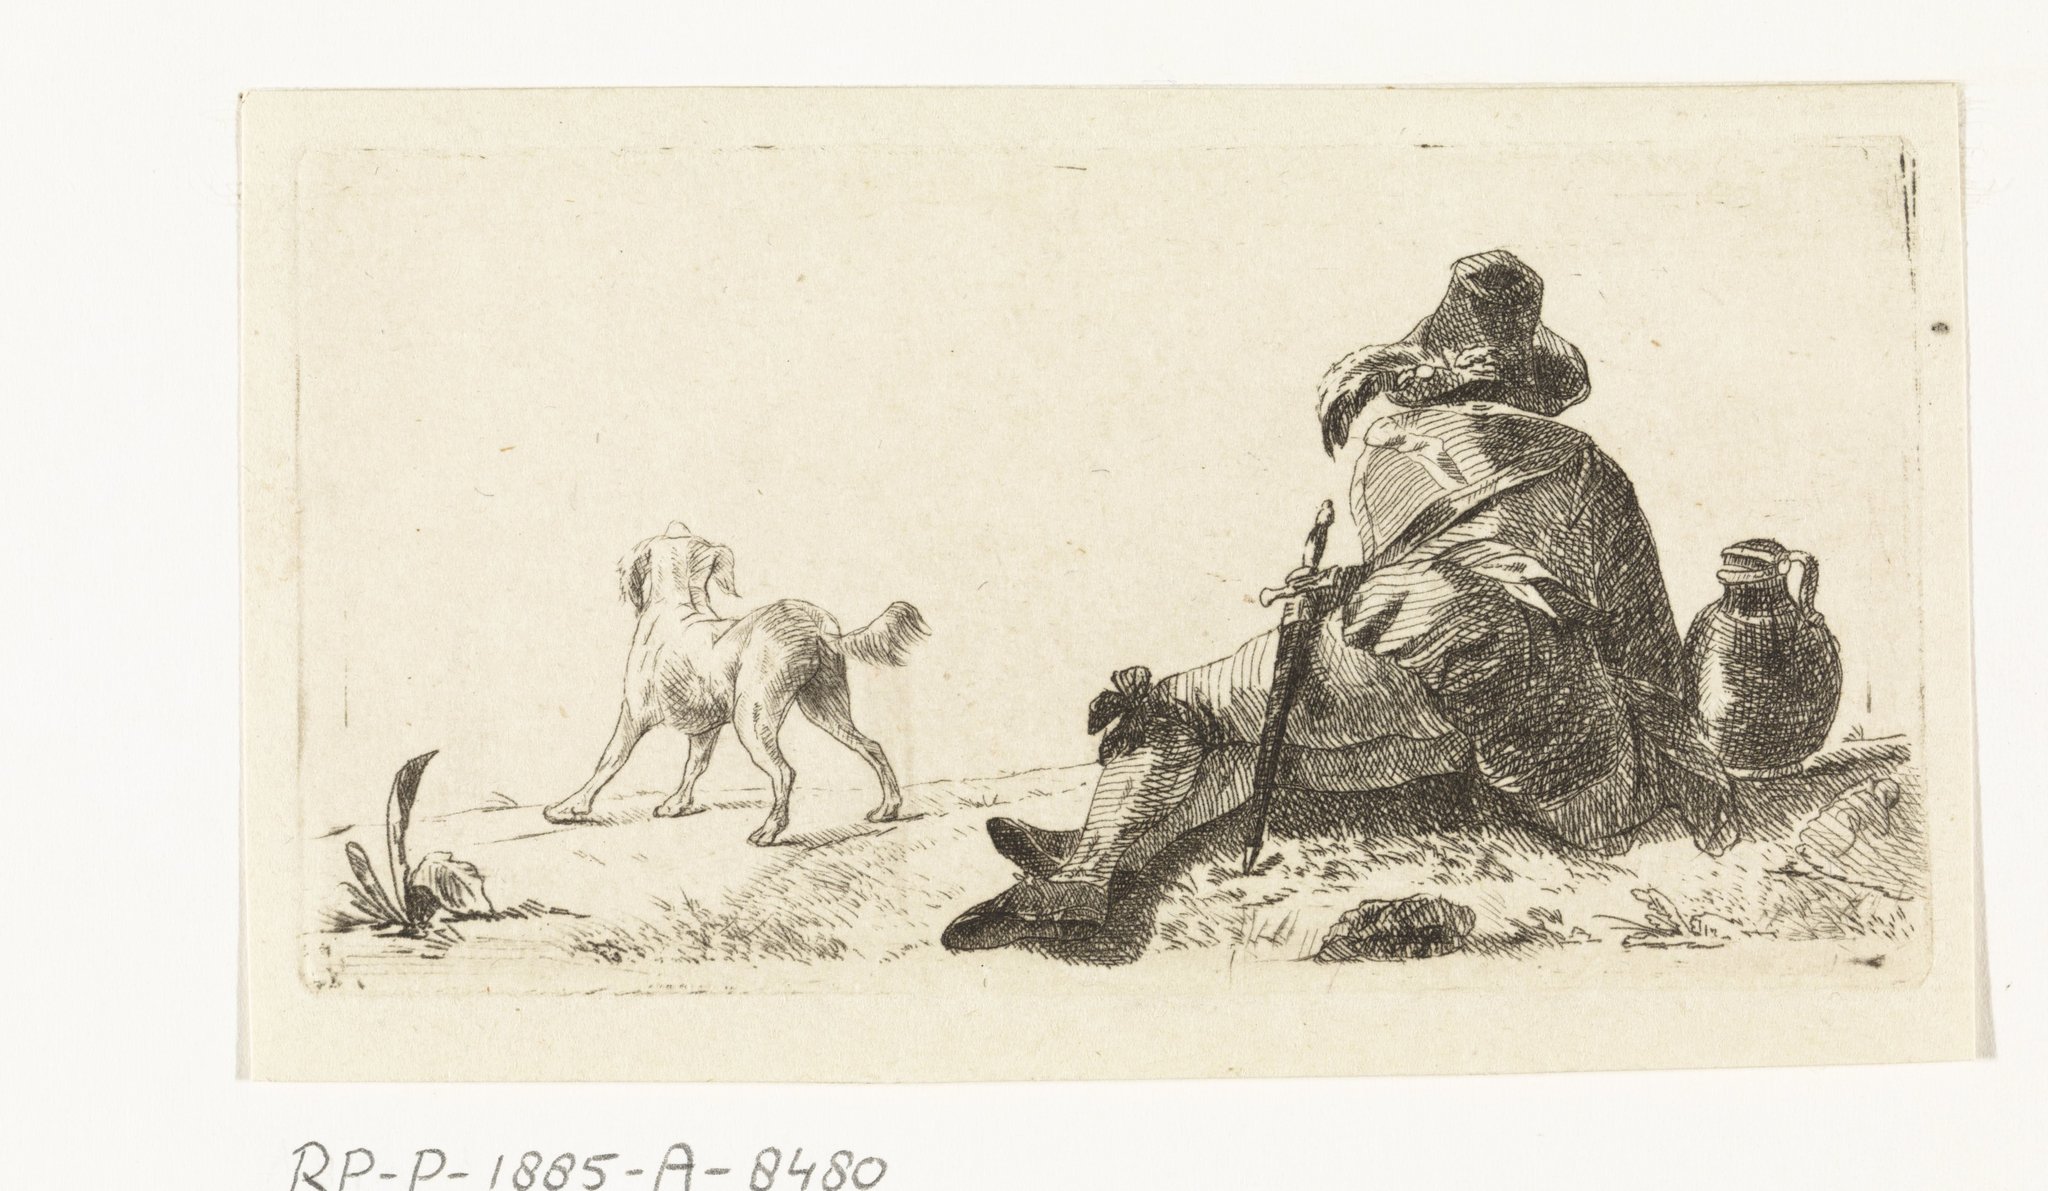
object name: print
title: Man met hond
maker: paulus charles gerard poelman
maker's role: draughtsman, painter, print maker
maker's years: 1792-1846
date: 1803-1846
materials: paper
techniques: etching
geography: utrecht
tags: dog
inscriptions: collector's mark: Lugt 2228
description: Een man, op de rug gezien, zit op de grond met naast hem een kruik. Hij draagt een zwaard en een hoed met veren. Schuin voor hem staat een blaffende hond, eveneens van achteren gezien.